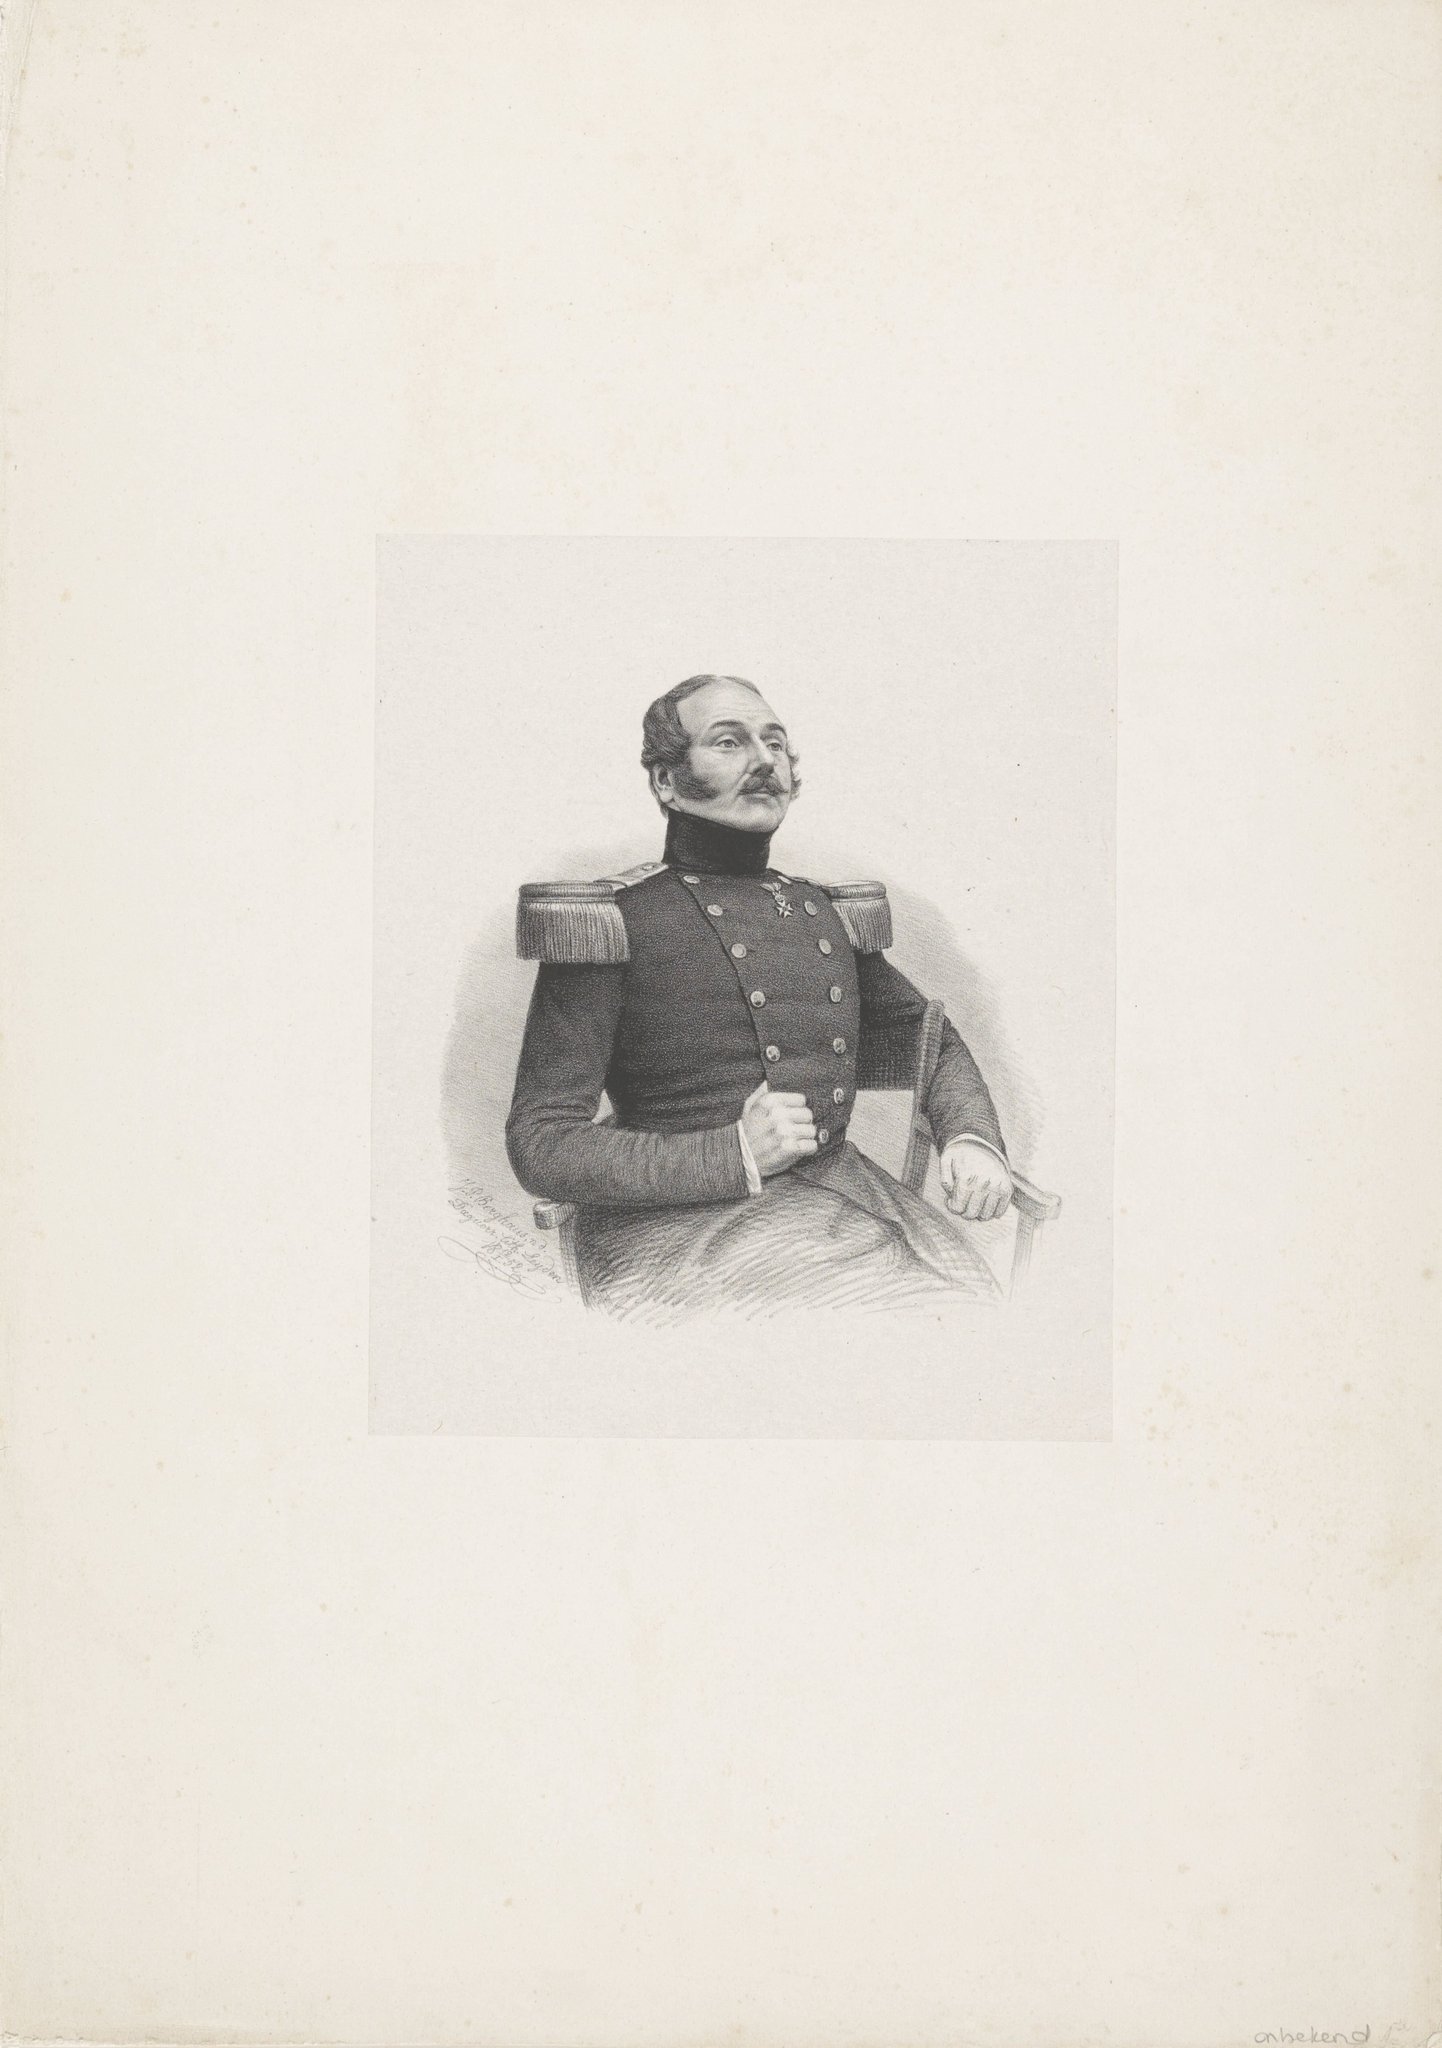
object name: print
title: Portret van een onbekende man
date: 1852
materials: paper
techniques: lithograph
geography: leiden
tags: knighthood order, historical persons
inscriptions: collector's mark: Lugt 2228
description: De geportretteerde draagt een militair uniform met een ridderorde op zijn borst. De duim van zijn rechterhand heeft hij voor zijn buik in zijn jas geschoven. Hij kijkt naar rechtsboven.